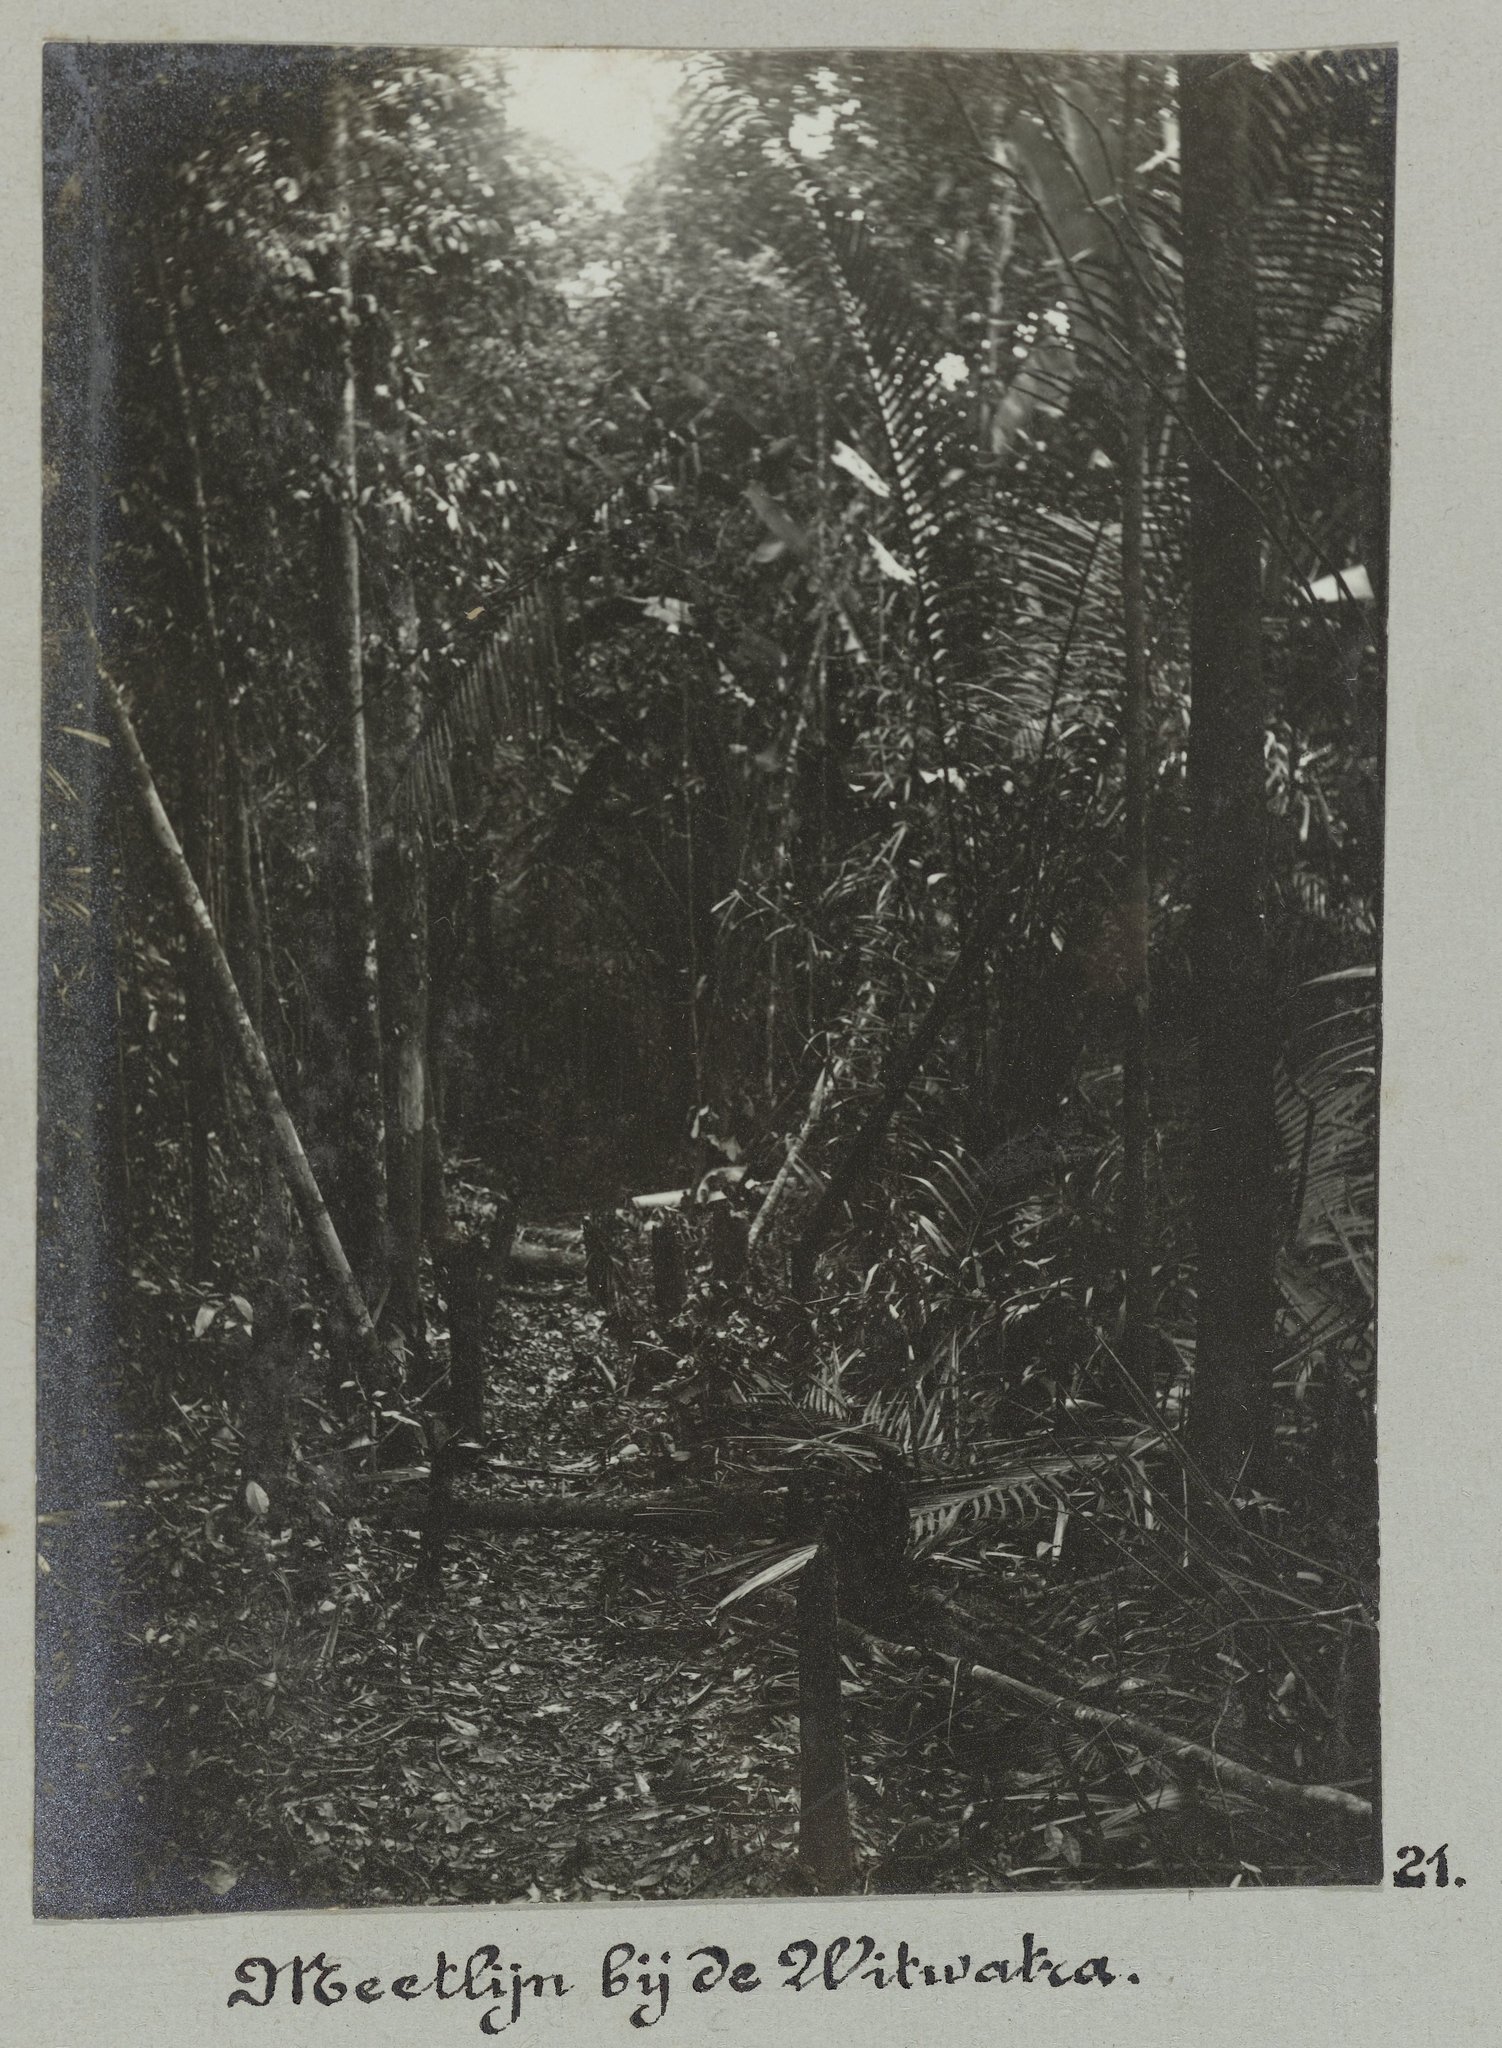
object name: photograph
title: Meetlijn bij de Witwatra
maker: hendrik doijer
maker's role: engineer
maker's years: 1863-1925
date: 1903-1910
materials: photographic support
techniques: gelatin silver print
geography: suriname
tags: suriname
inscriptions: inscription: ‘21. / Meetlijn bij de Witwatra.’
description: Meetlijn in het oerwoud. Onderdeel van het fotoalbum Souvenir de Voyage (deel 1), over het leven van de familie Doijer in en rond de plantage Ma Retraite in Suriname in de jaren 1903-1910.